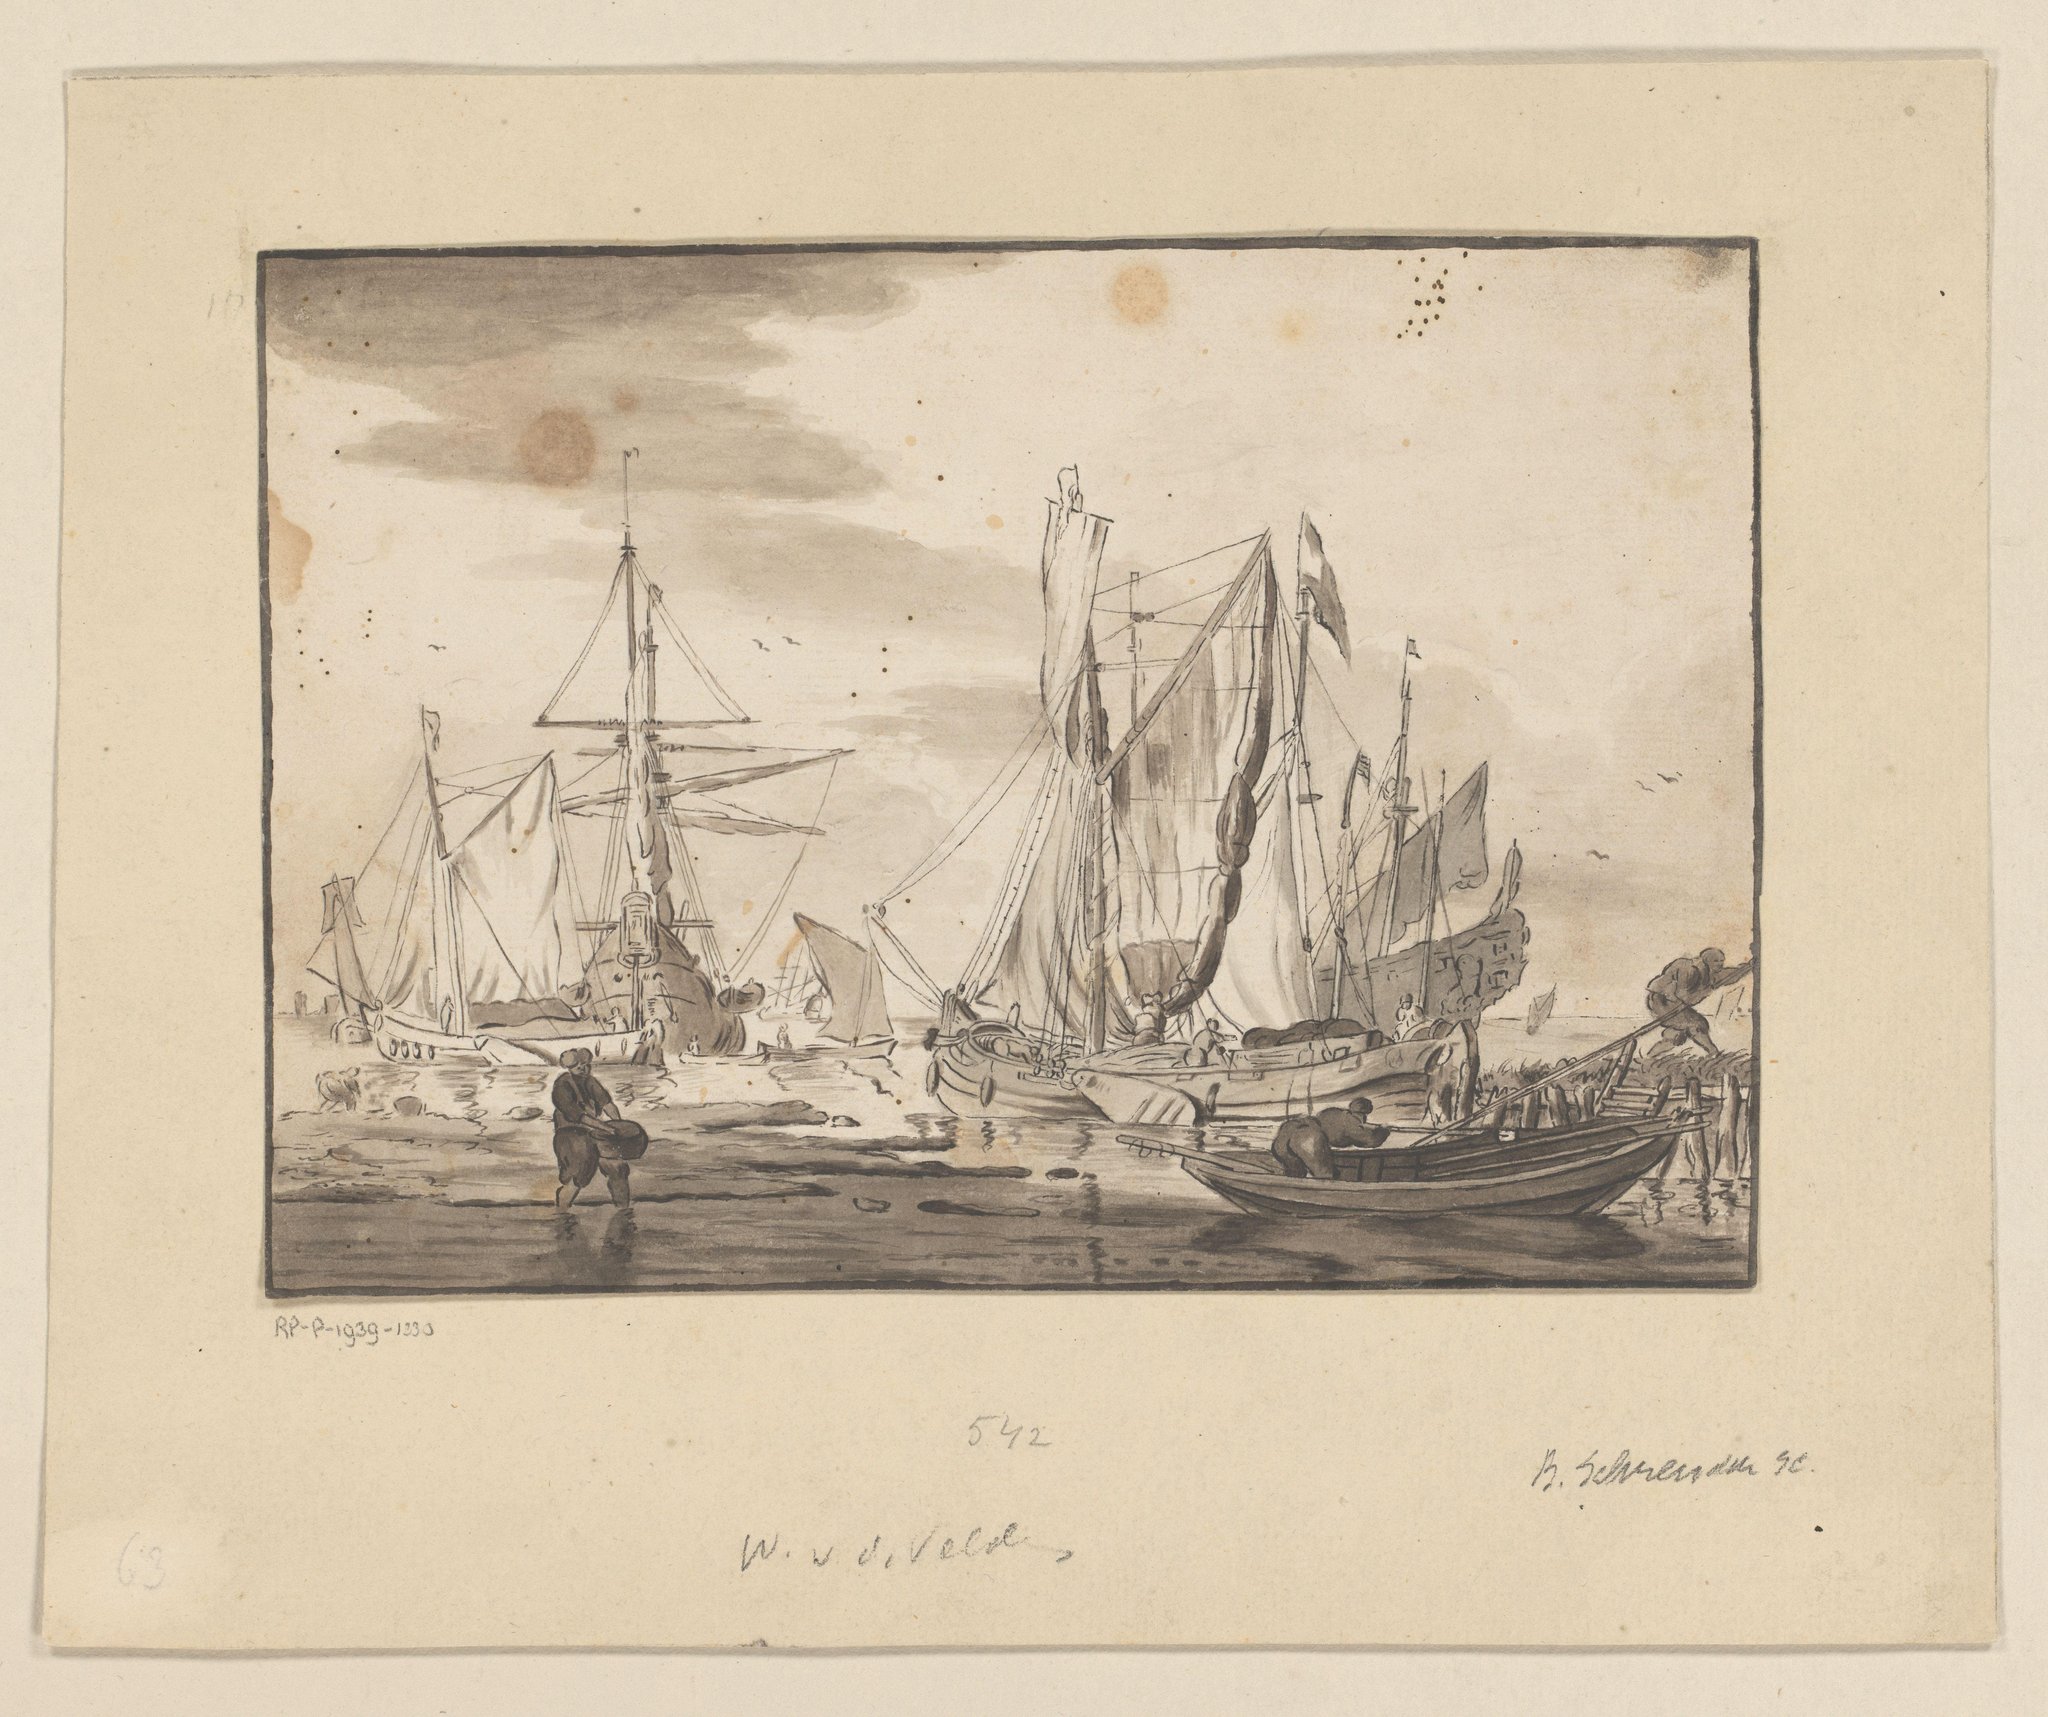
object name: drawing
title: Lossen van aangemeerde schepen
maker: bernhard schreuder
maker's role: print maker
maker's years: -1780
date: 1767-1780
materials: ink, paper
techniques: brush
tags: ships, boats on land, beached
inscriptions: collector's mark: ‘RIJKS / MUSM’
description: Schepen voor de kust. Links een man met een mand in zijn handen. De tekening ligt los in een album.